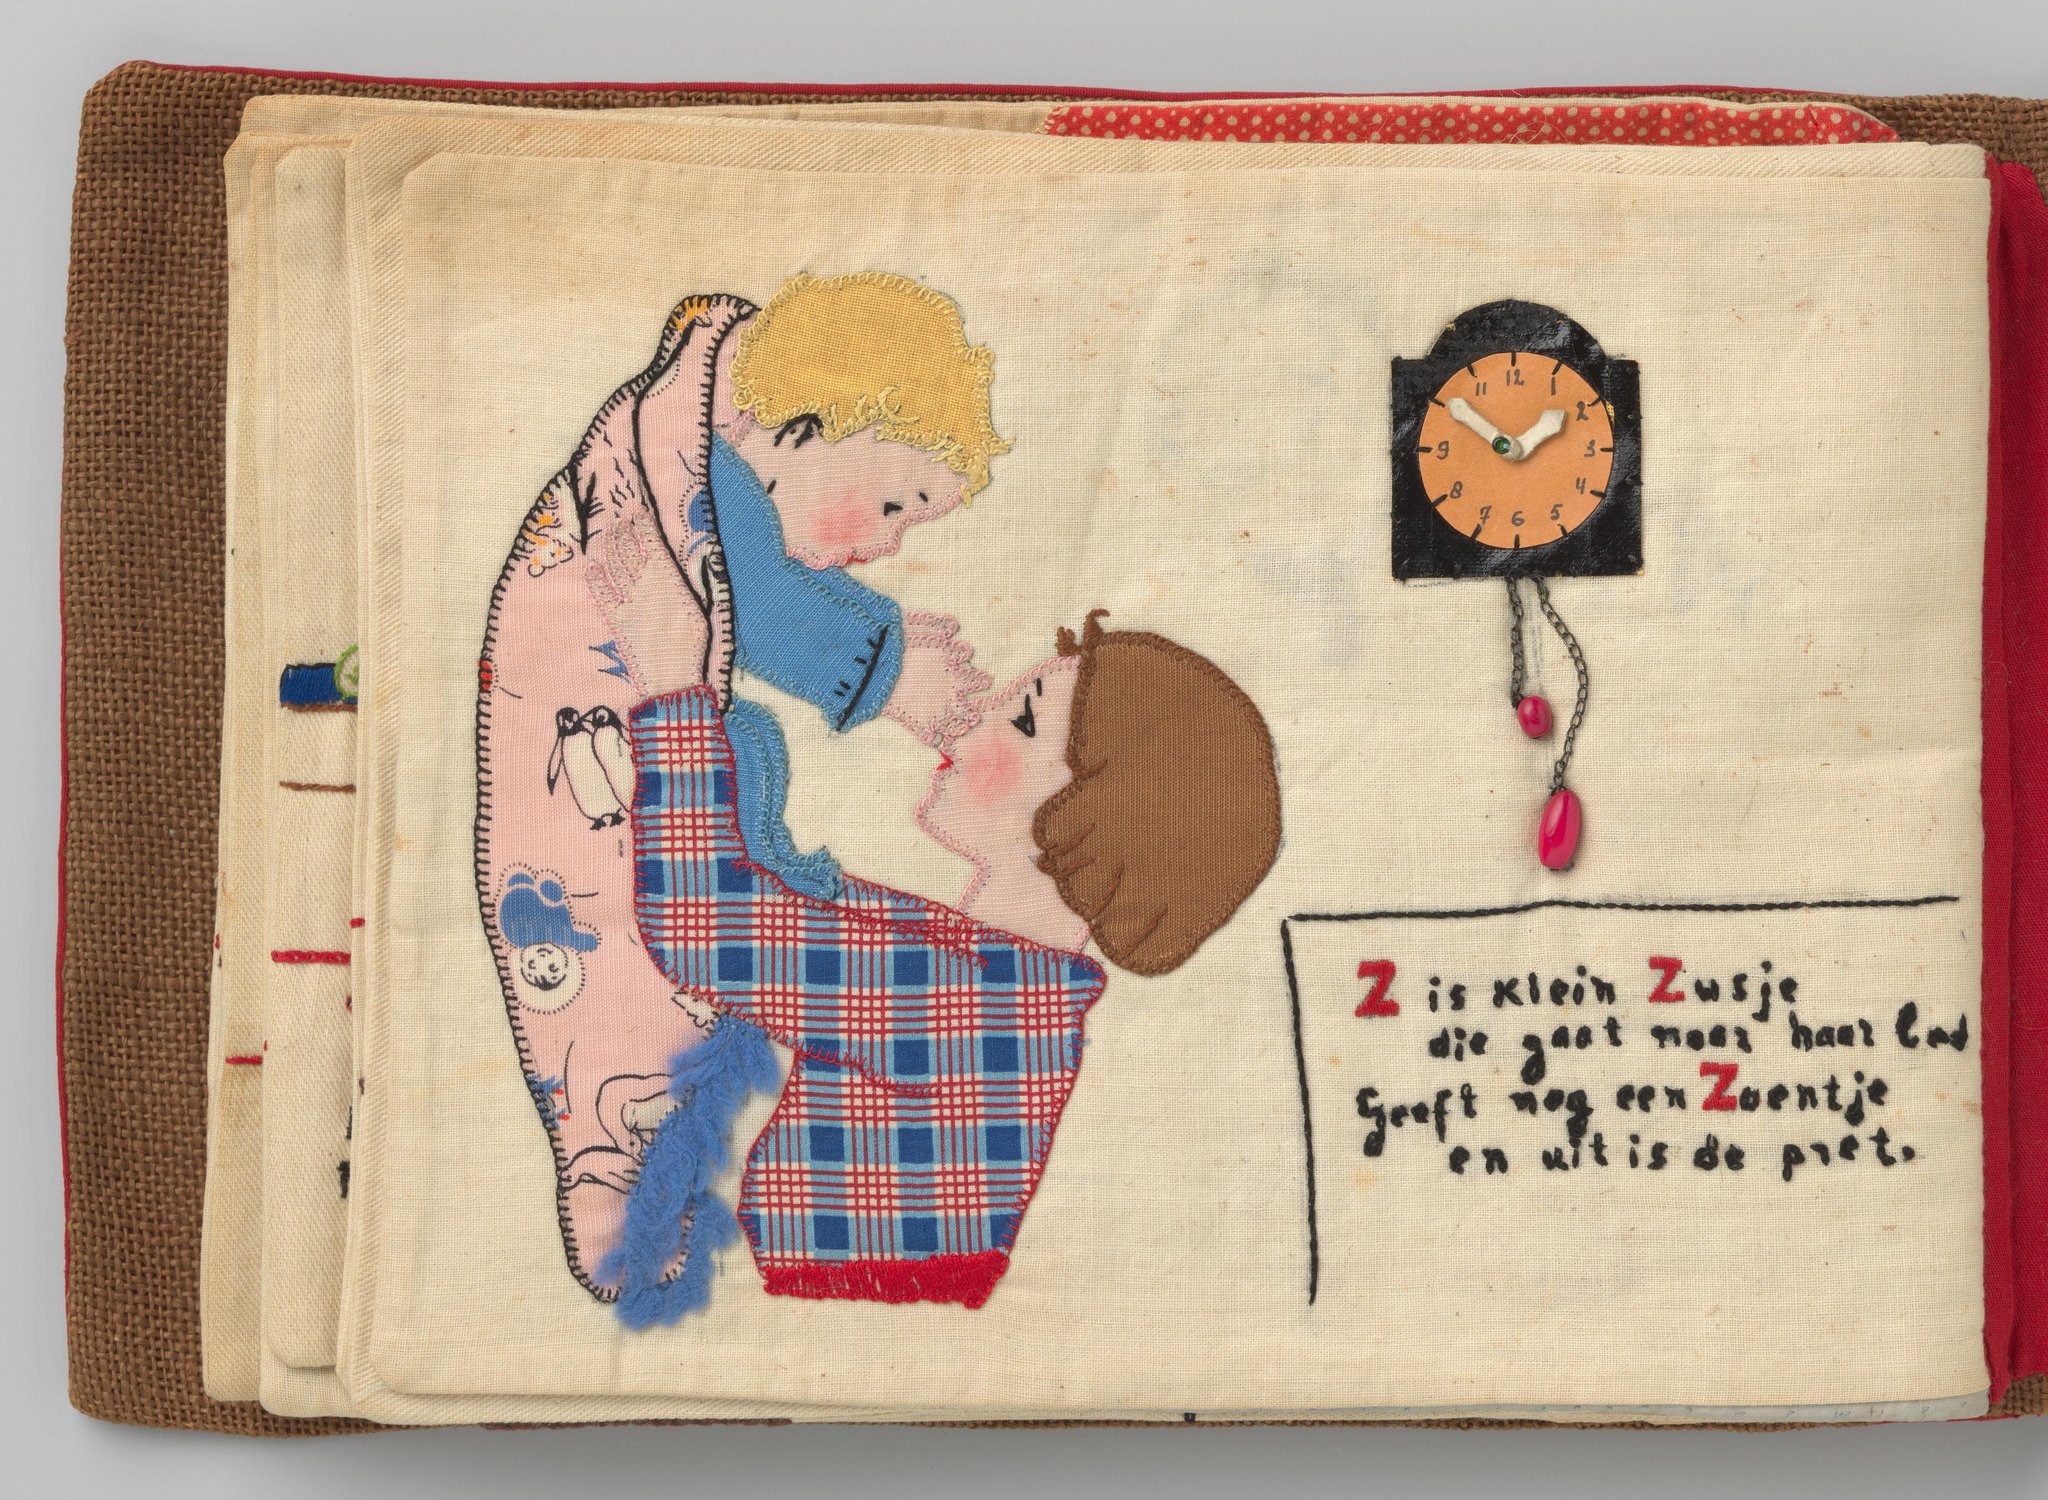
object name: blad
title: Z is klein Zusje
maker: miesje geertruida maria petronella aalbersberg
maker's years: 1915-1997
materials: cotton, textile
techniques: appliqué, embroidered, stitch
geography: brastagi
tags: reading, book in which illustrations are essential, letters, alphabet, script, internment camp, nursery school (+ teaching aids), (other forms of) needlework, e.g.: crocheting, knitting, embroidering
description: In het geheim gemaakt kinderboek in textiel vrij naar A is een Aapje van Rie Cramer. Het werd gezamenlijk gemaakt door de vrouwelijke gevangenen van het Japanse interneringskamp Brastagi, een oude plantage in Noord-Sumatra 60 kilometer ten zuiden van Medan aan de weg naar het Toba-meer, tijdens de Tweede Wereldoorlog ter gelegenheid van de vijfde verjaardag van Pem Hagers, de dochter van Miesje Hagers-Aalbersberg die de ontwerptekeningen en sjablonen had gemaakt.